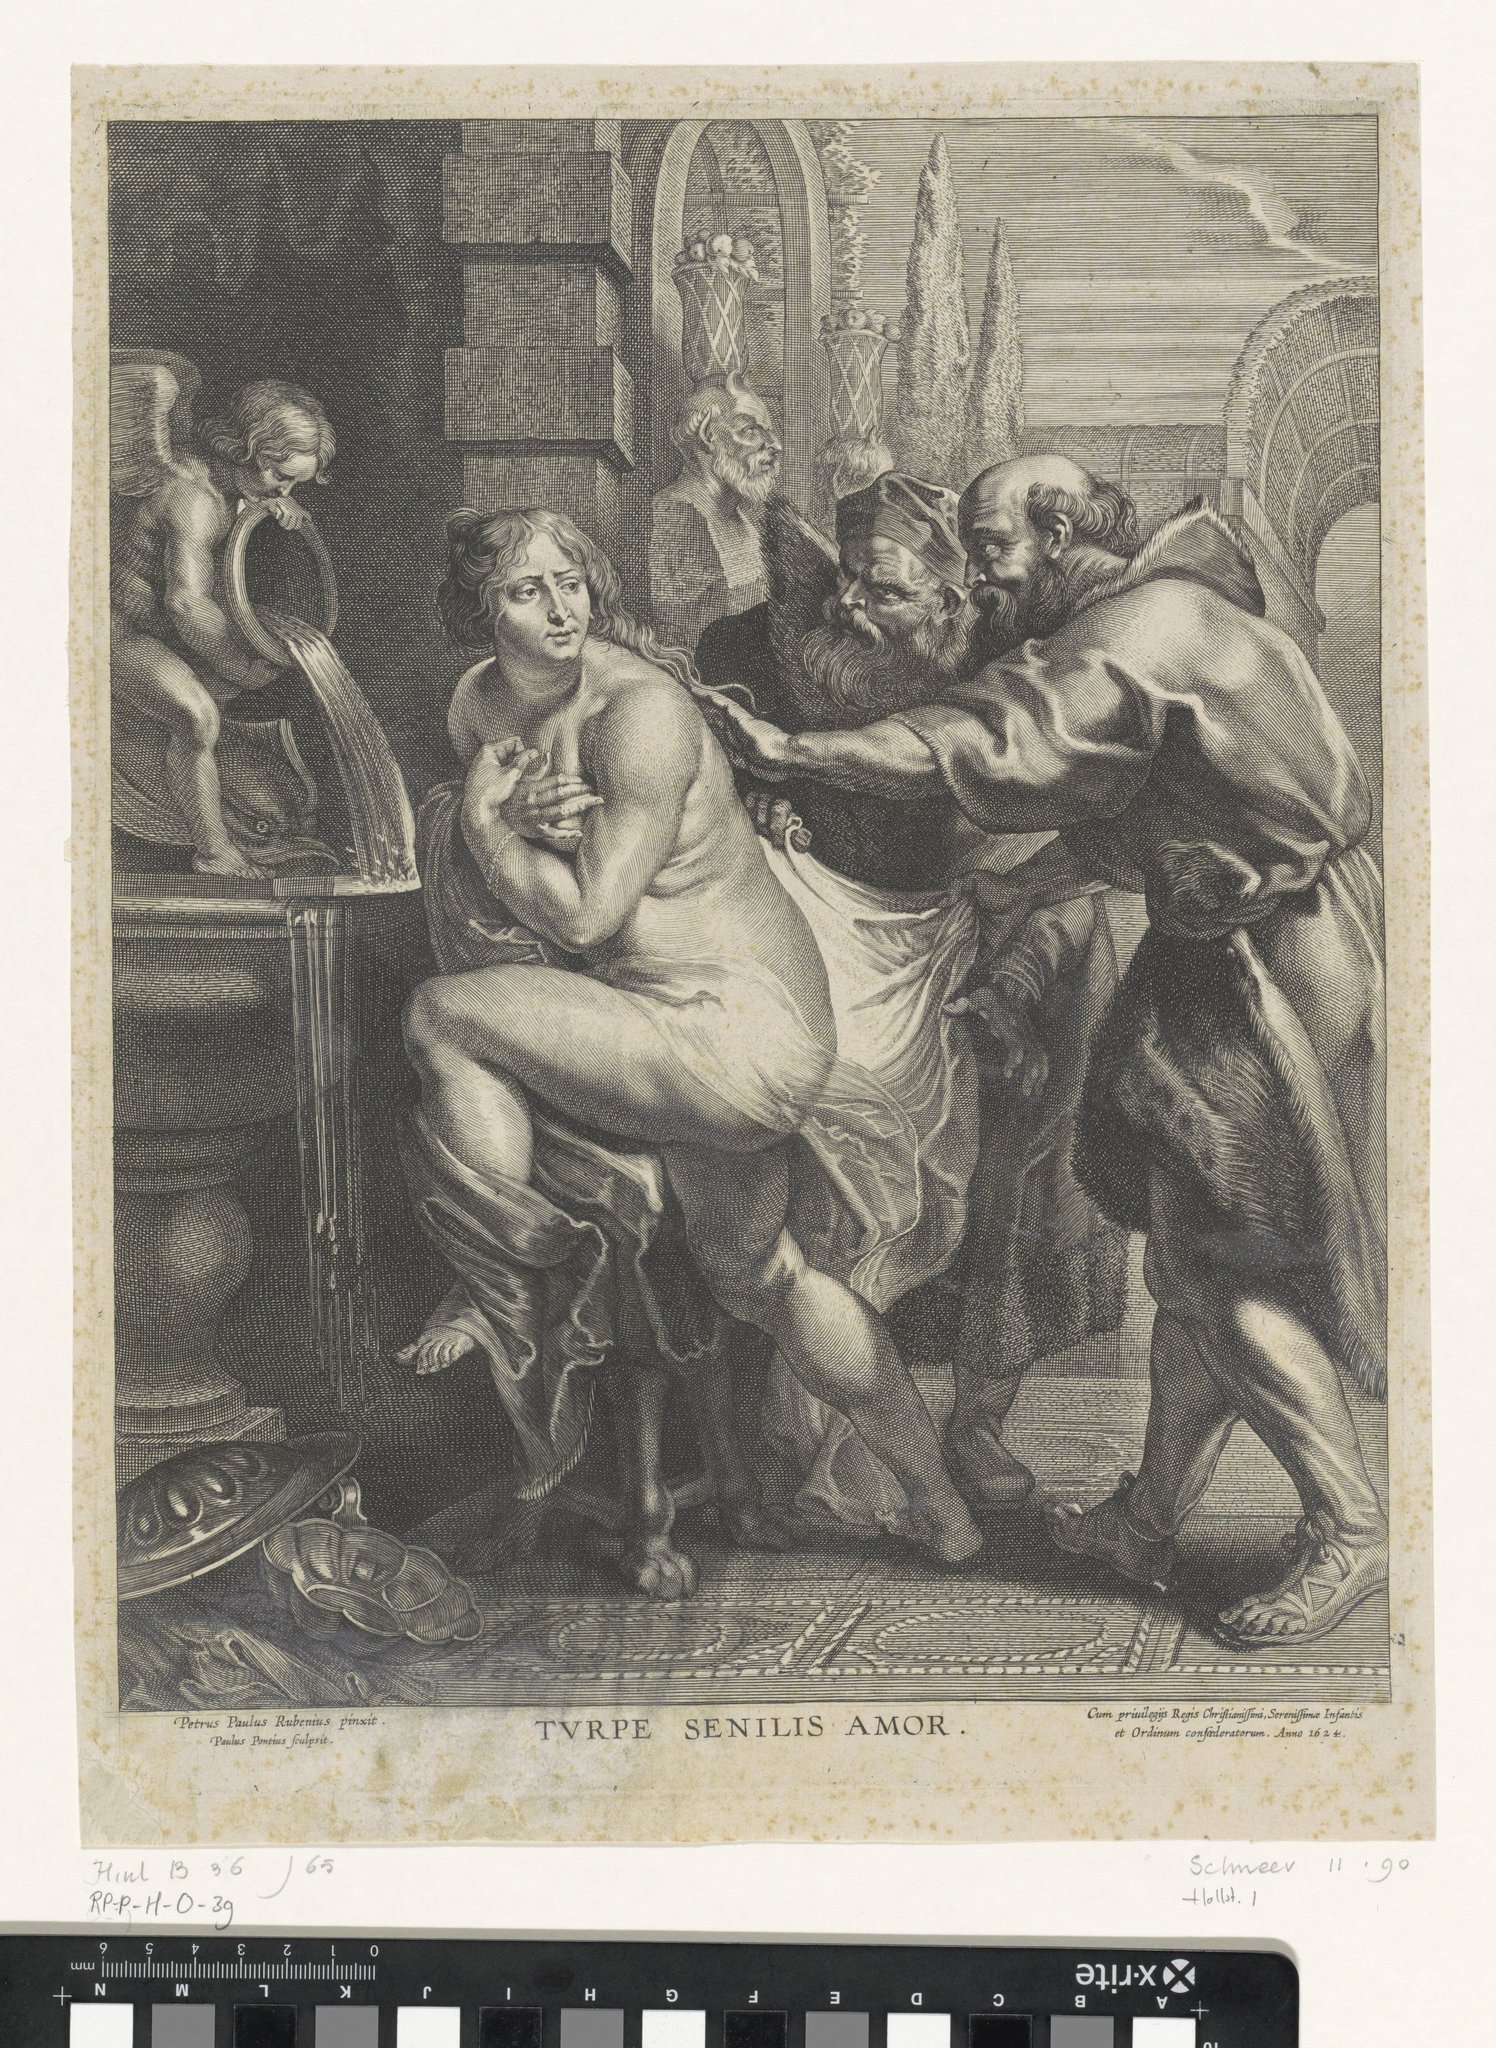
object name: print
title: Suzanna en de ouderlingen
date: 1624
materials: paper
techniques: engraving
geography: antwerp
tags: the elders making advances towards susanna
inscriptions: collector's mark: Lugt 10, collector's mark: Lugt 11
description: Susanna wordt bij het baden door twee oudsten betast. Ze probeert haar lichaam te bedekken.